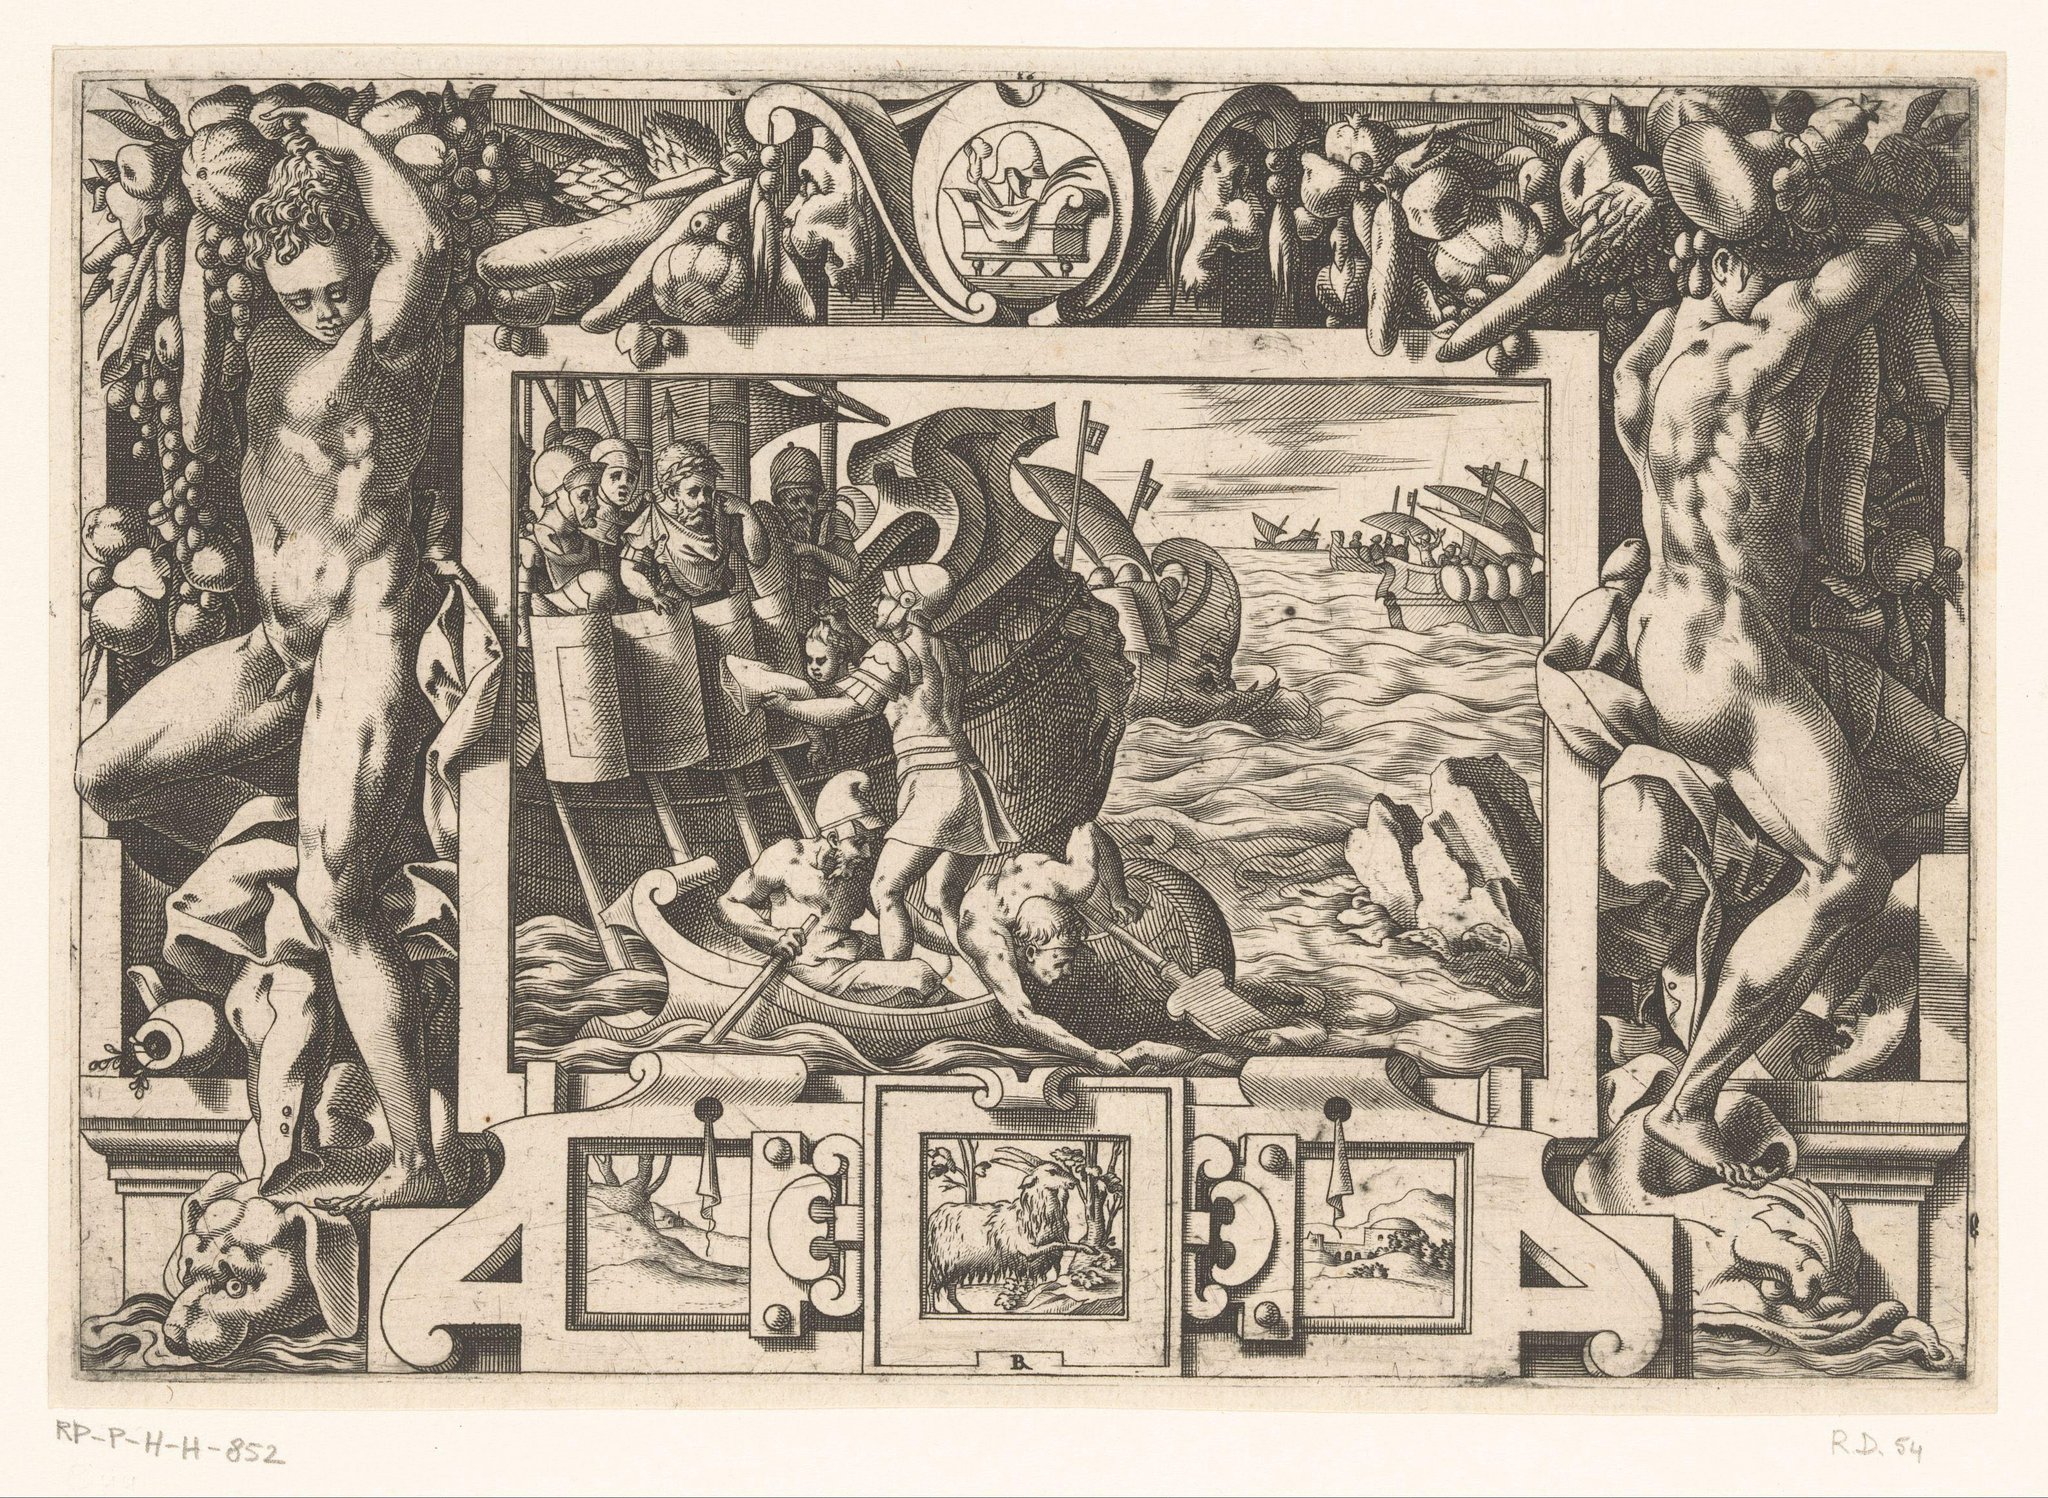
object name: print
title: Histoire de Jason et de la conquête de la toison d'or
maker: rené boyvin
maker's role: print maker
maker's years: 1525-1598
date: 1563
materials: paper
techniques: engraving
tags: aeetes, in pursuit of the argo, is obliged to stop to gather up apsyrtus' limbs, the story of the argonauts: the quest for the golden fleece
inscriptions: collector's mark: Lugt 11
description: Maakt deel uit van een serie van 26 prenten met scènes uit het verhaal van Jason en het gulden vlies, uitgegeven in 1563 te Parijs.